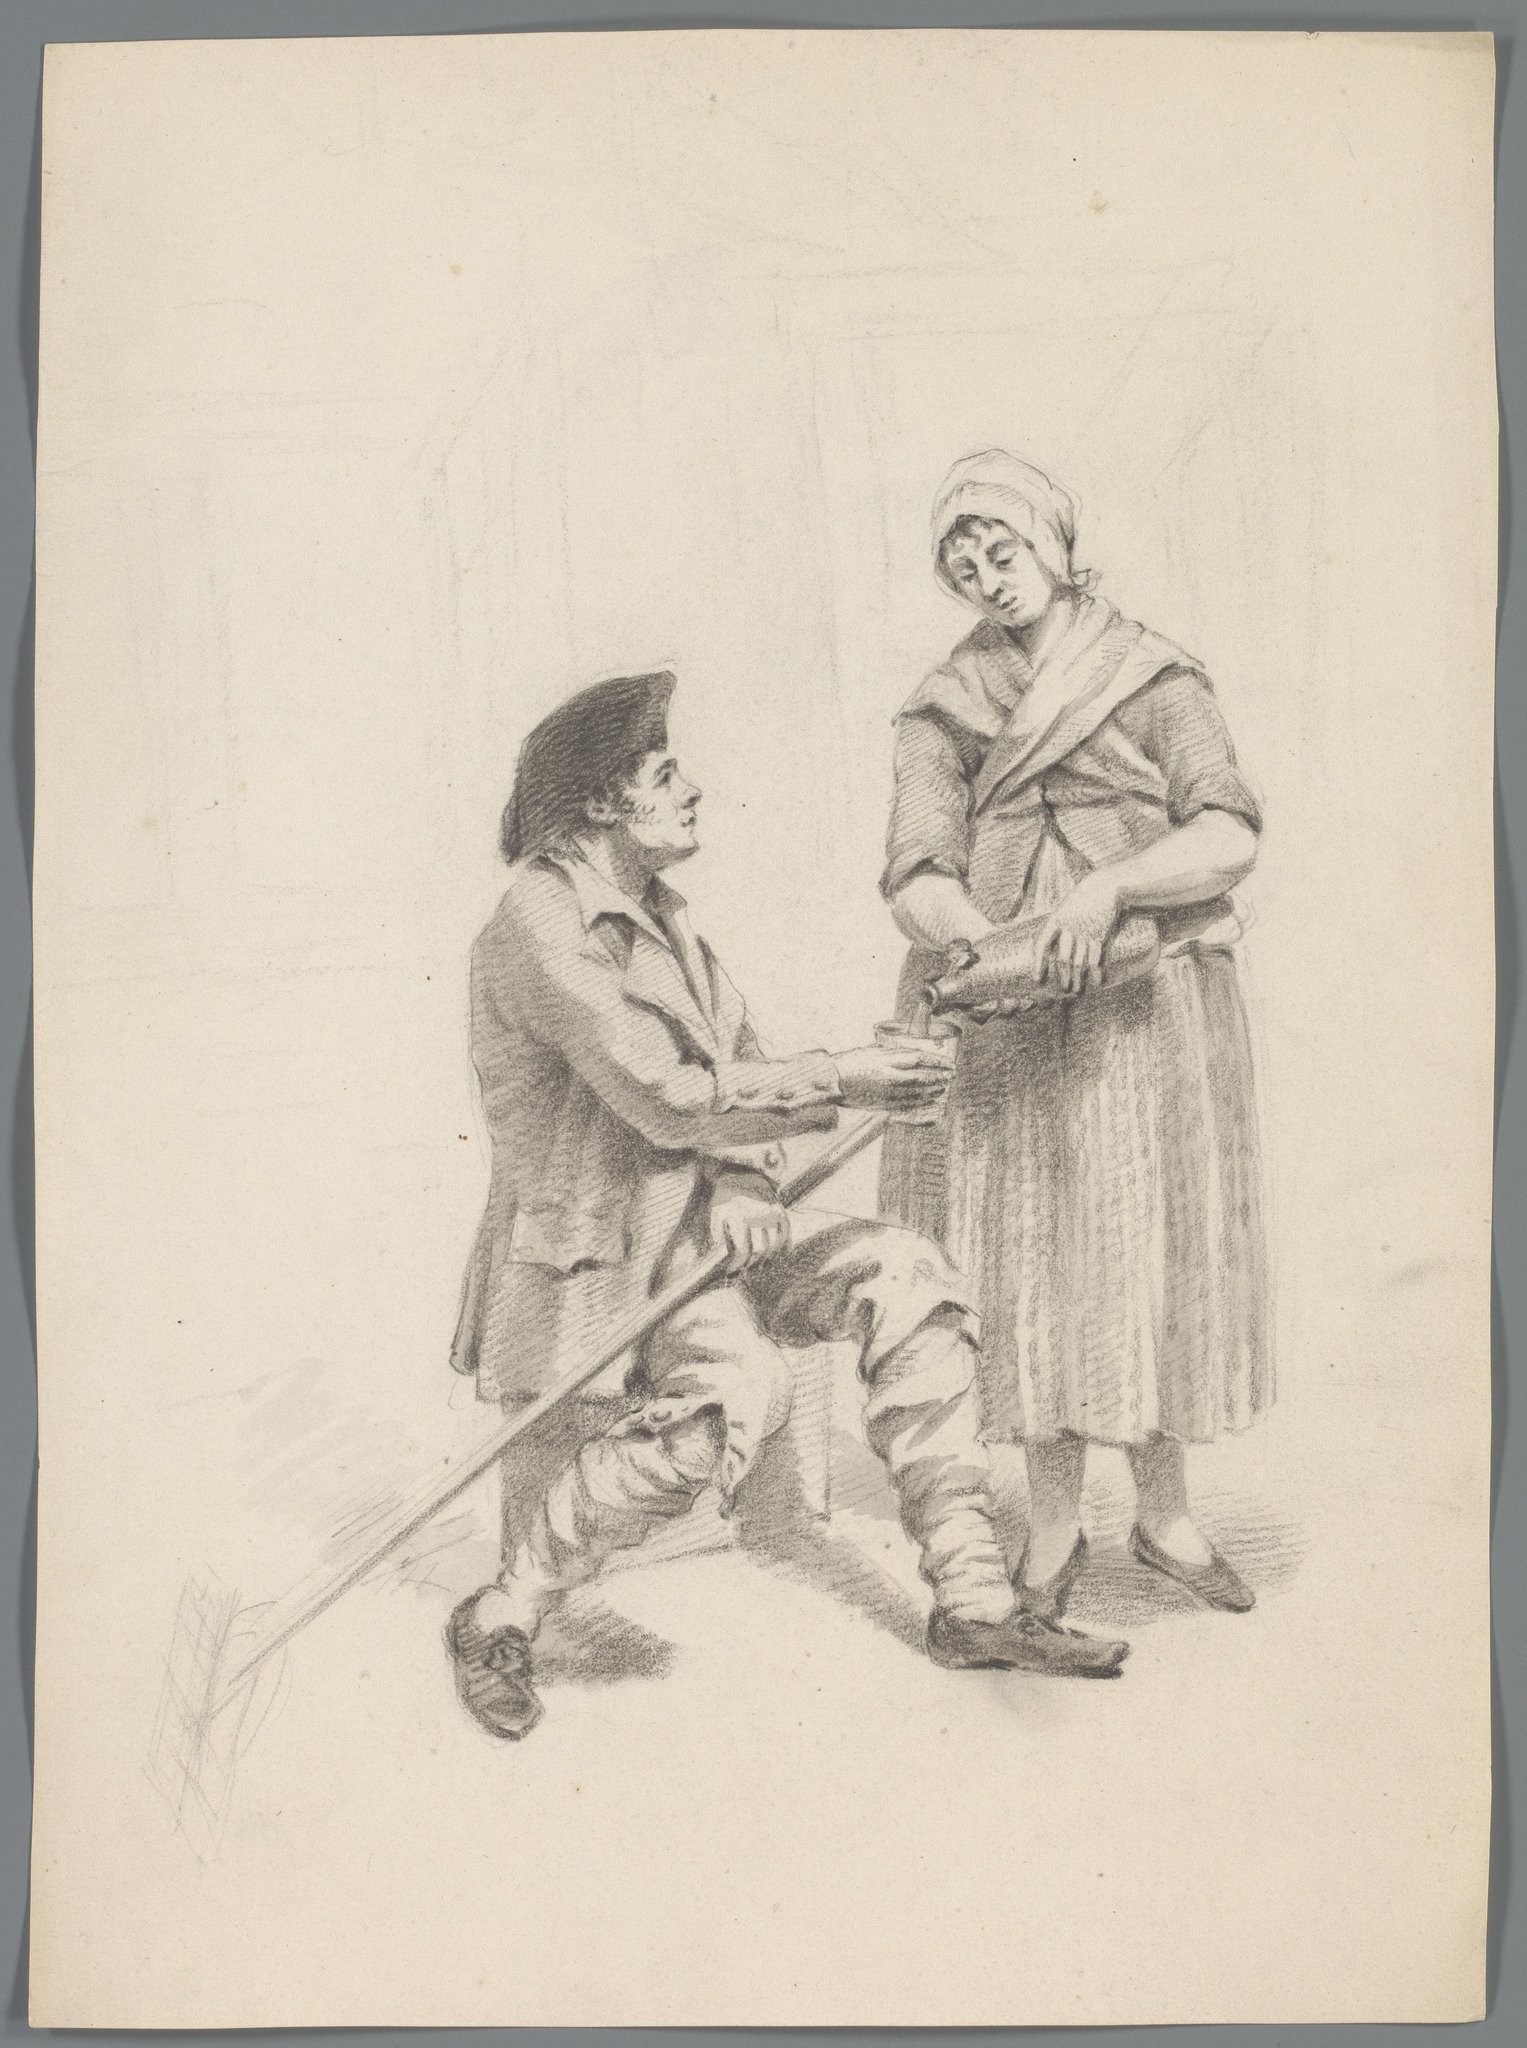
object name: drawing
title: Vrouw schenkt drinken in voor een man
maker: Anonymous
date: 1820-1830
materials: chalk, paper, watercolor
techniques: brush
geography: the hague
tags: sitting figure, adult woman, pouring, adult man, drinking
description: Tekeningen waarschijnlijk ontstaan bij het Haagse kunstgenootschap ‘Tot Nut der Tekenkunst’, waar twee keer per week tekenavonden werden georganiseerd met geklede modellen.